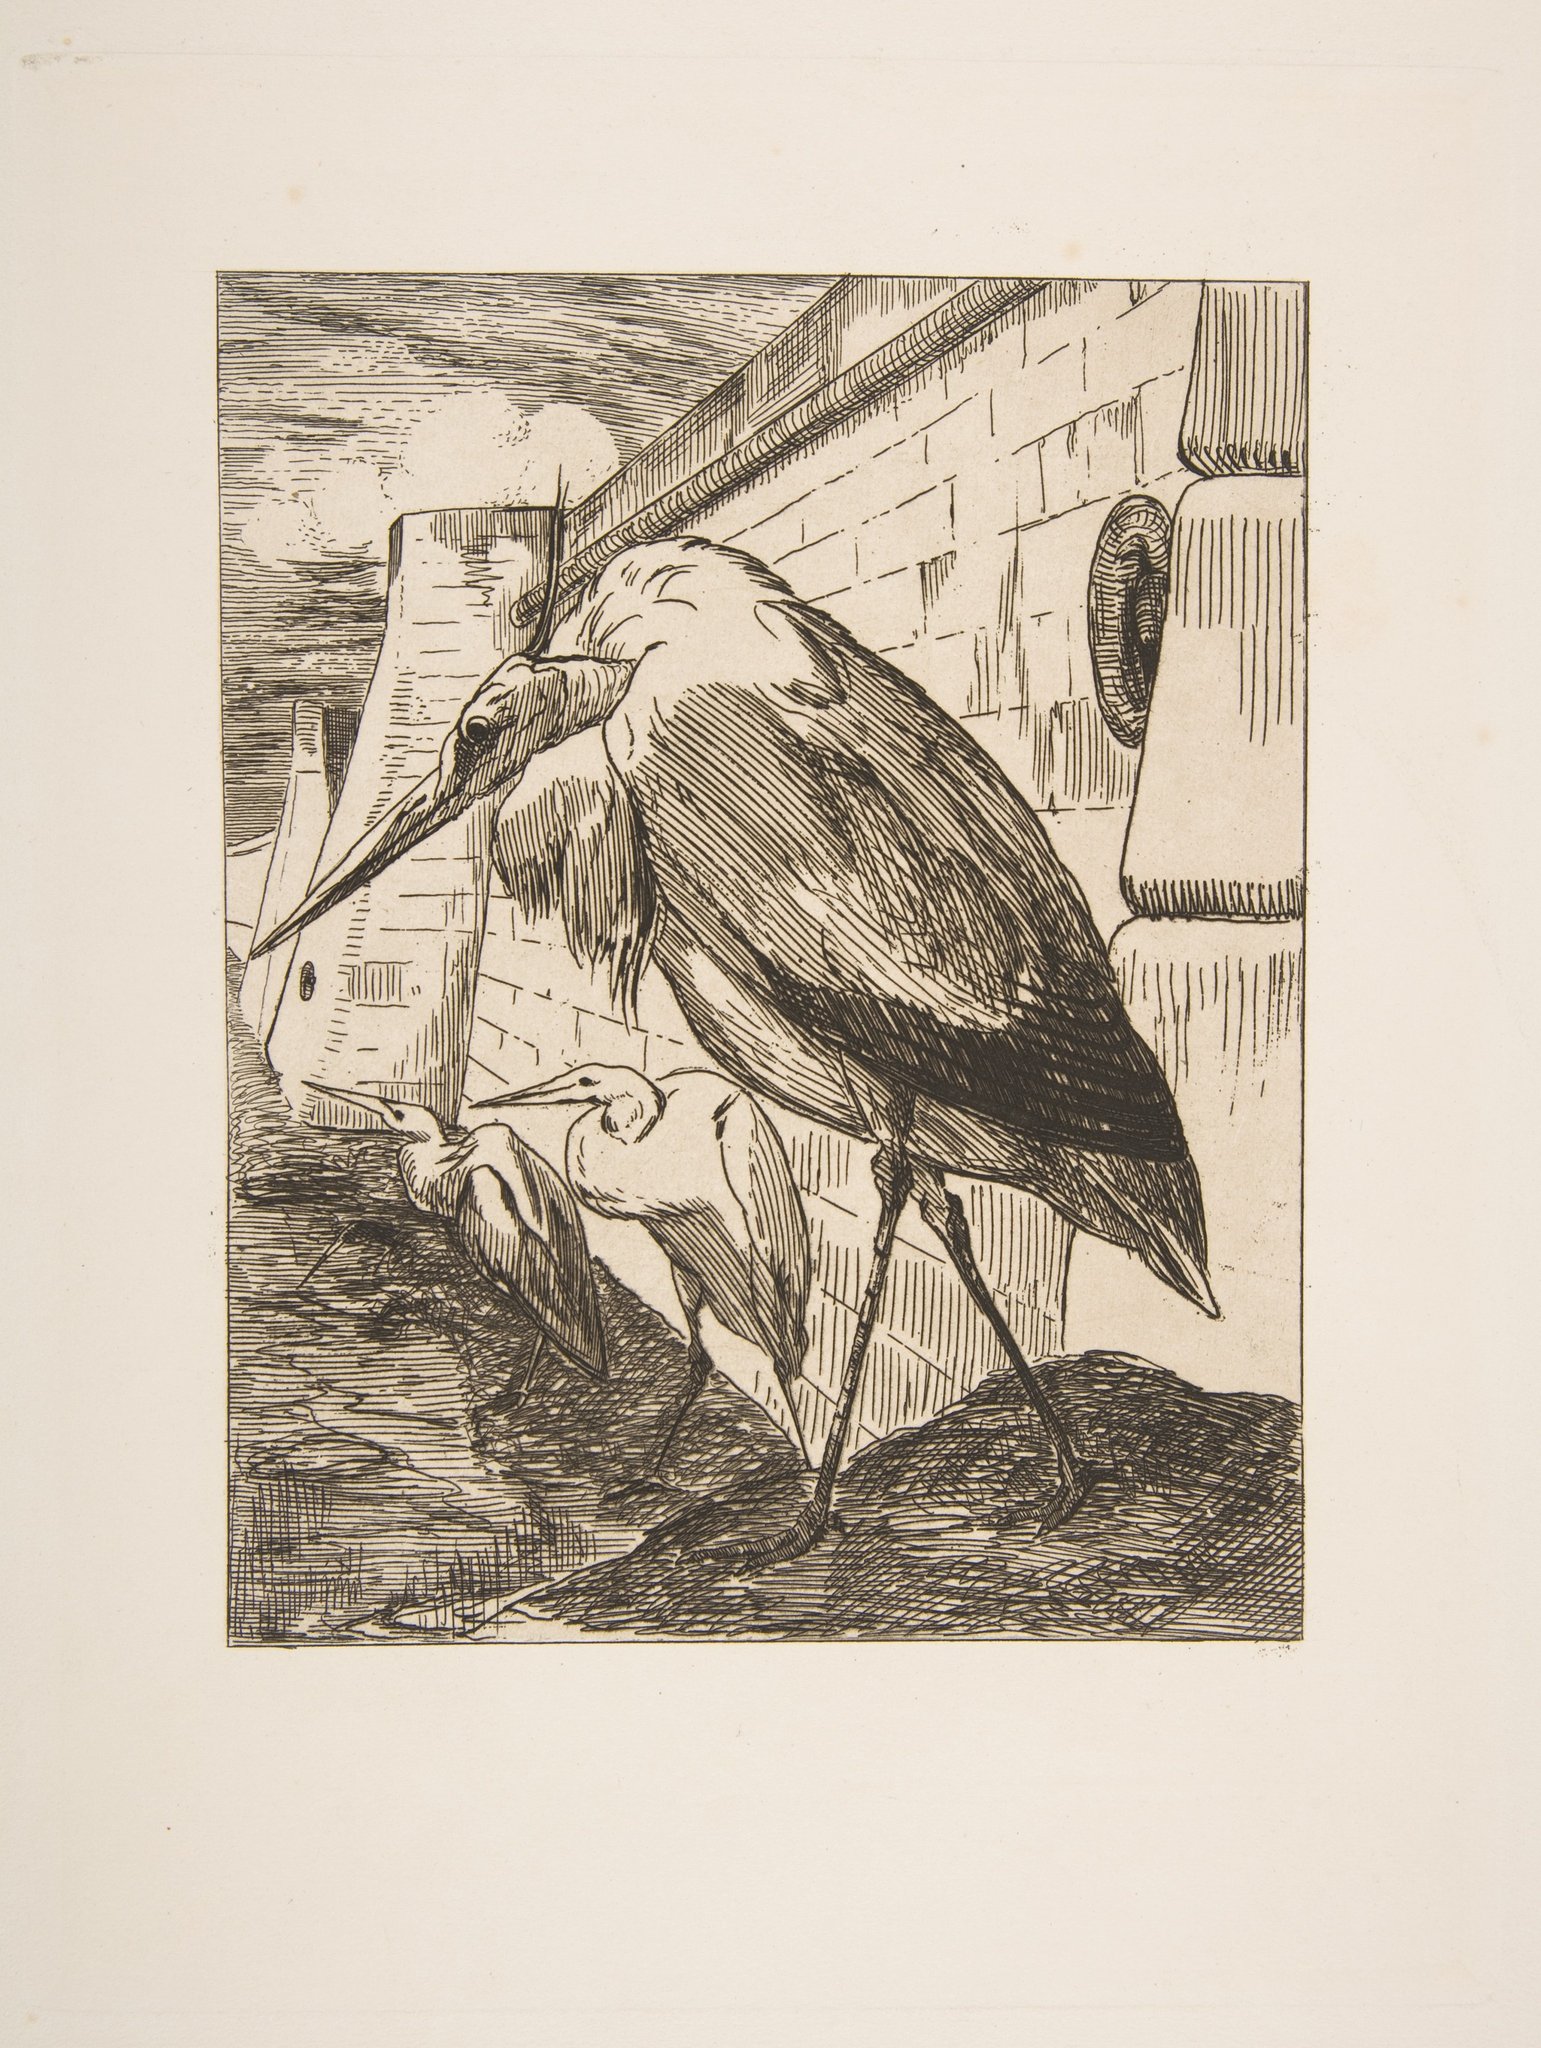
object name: print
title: Les Cigognes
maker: félix bracquemond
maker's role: artist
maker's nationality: french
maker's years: 1833-1914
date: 1870-1879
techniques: etching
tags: birds